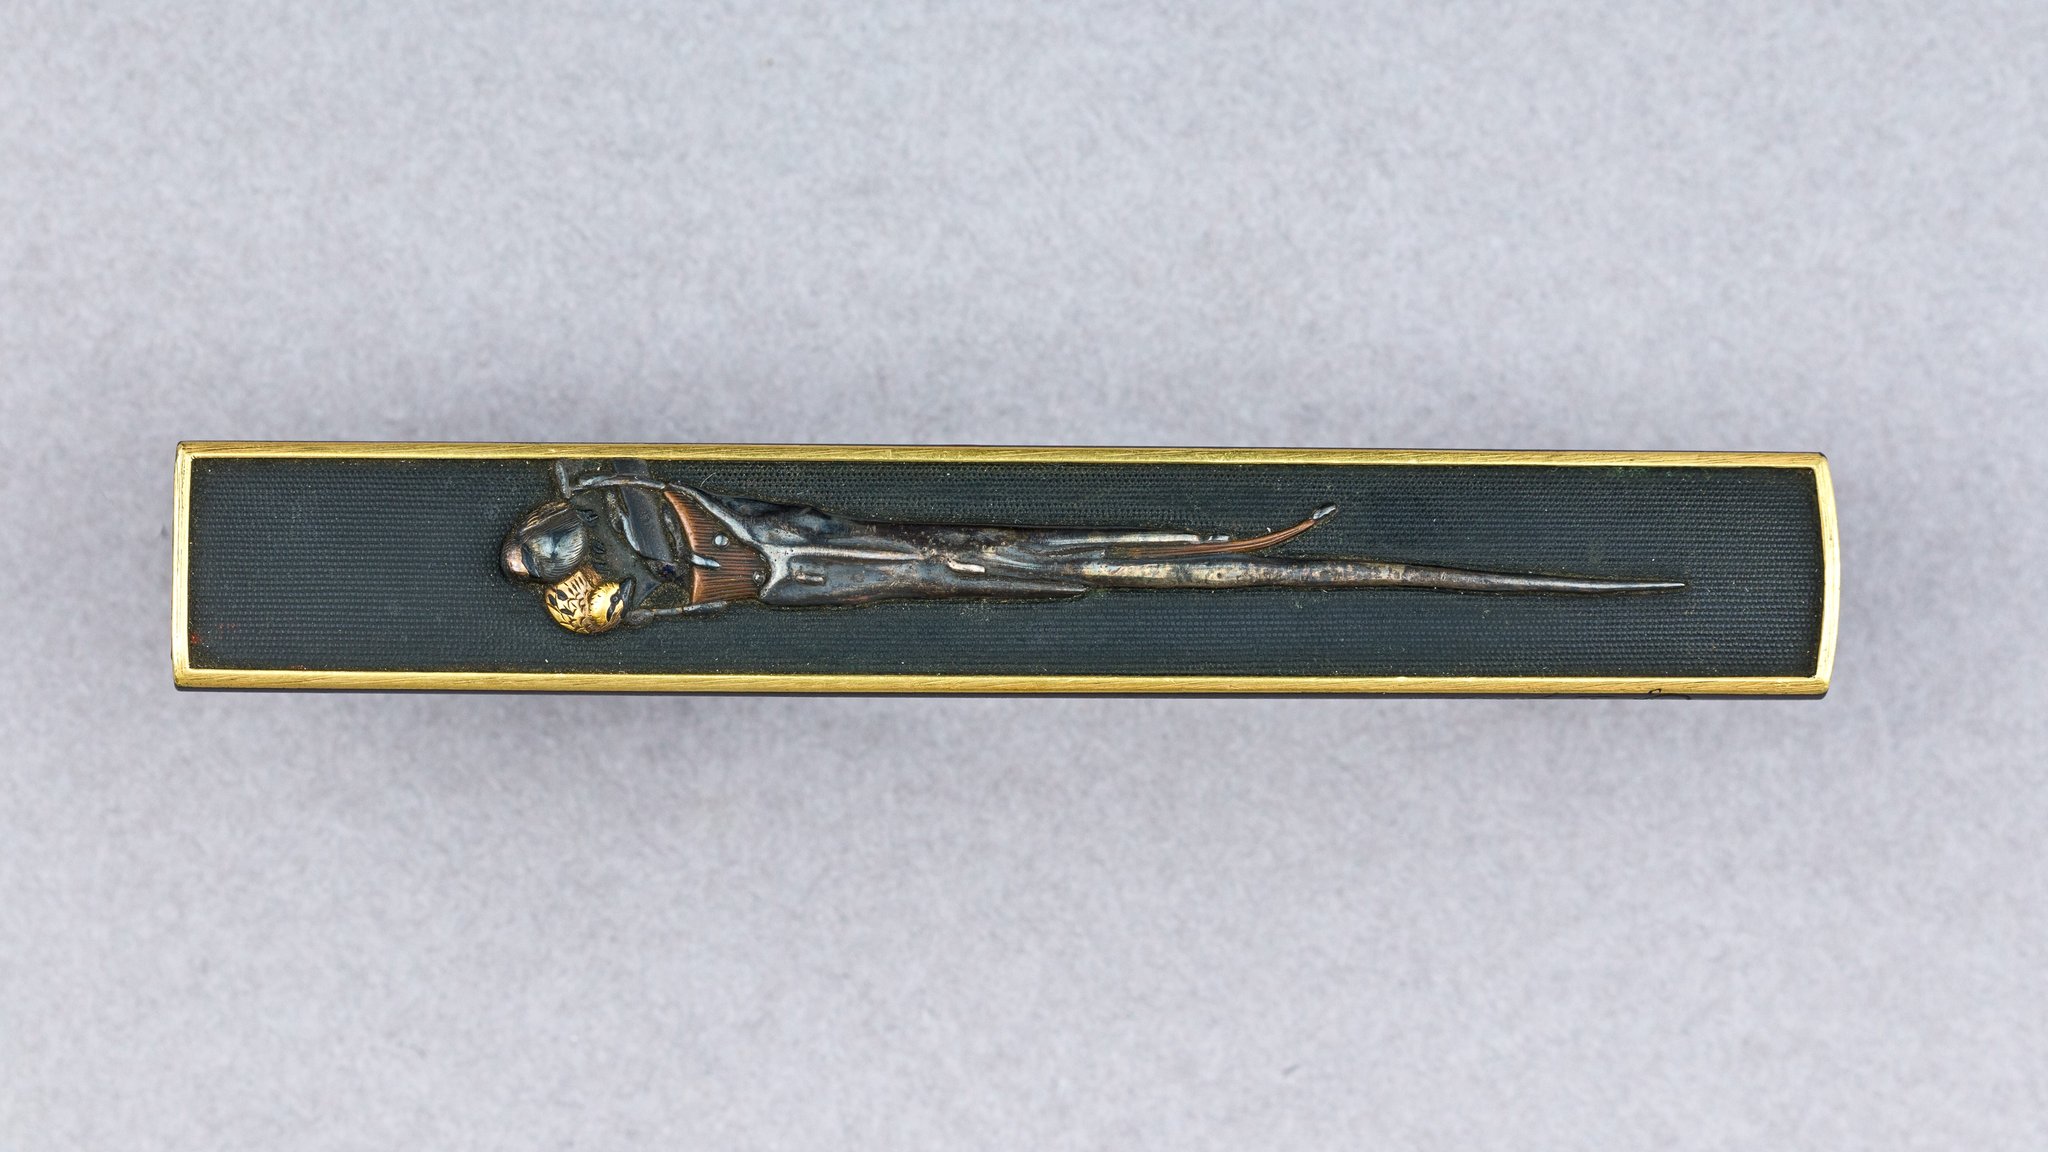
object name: knife handle kozuka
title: Knife Handle (Kozuka)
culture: japanese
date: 1801-1900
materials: copper, gold alloy, gold, silver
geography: japan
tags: birds